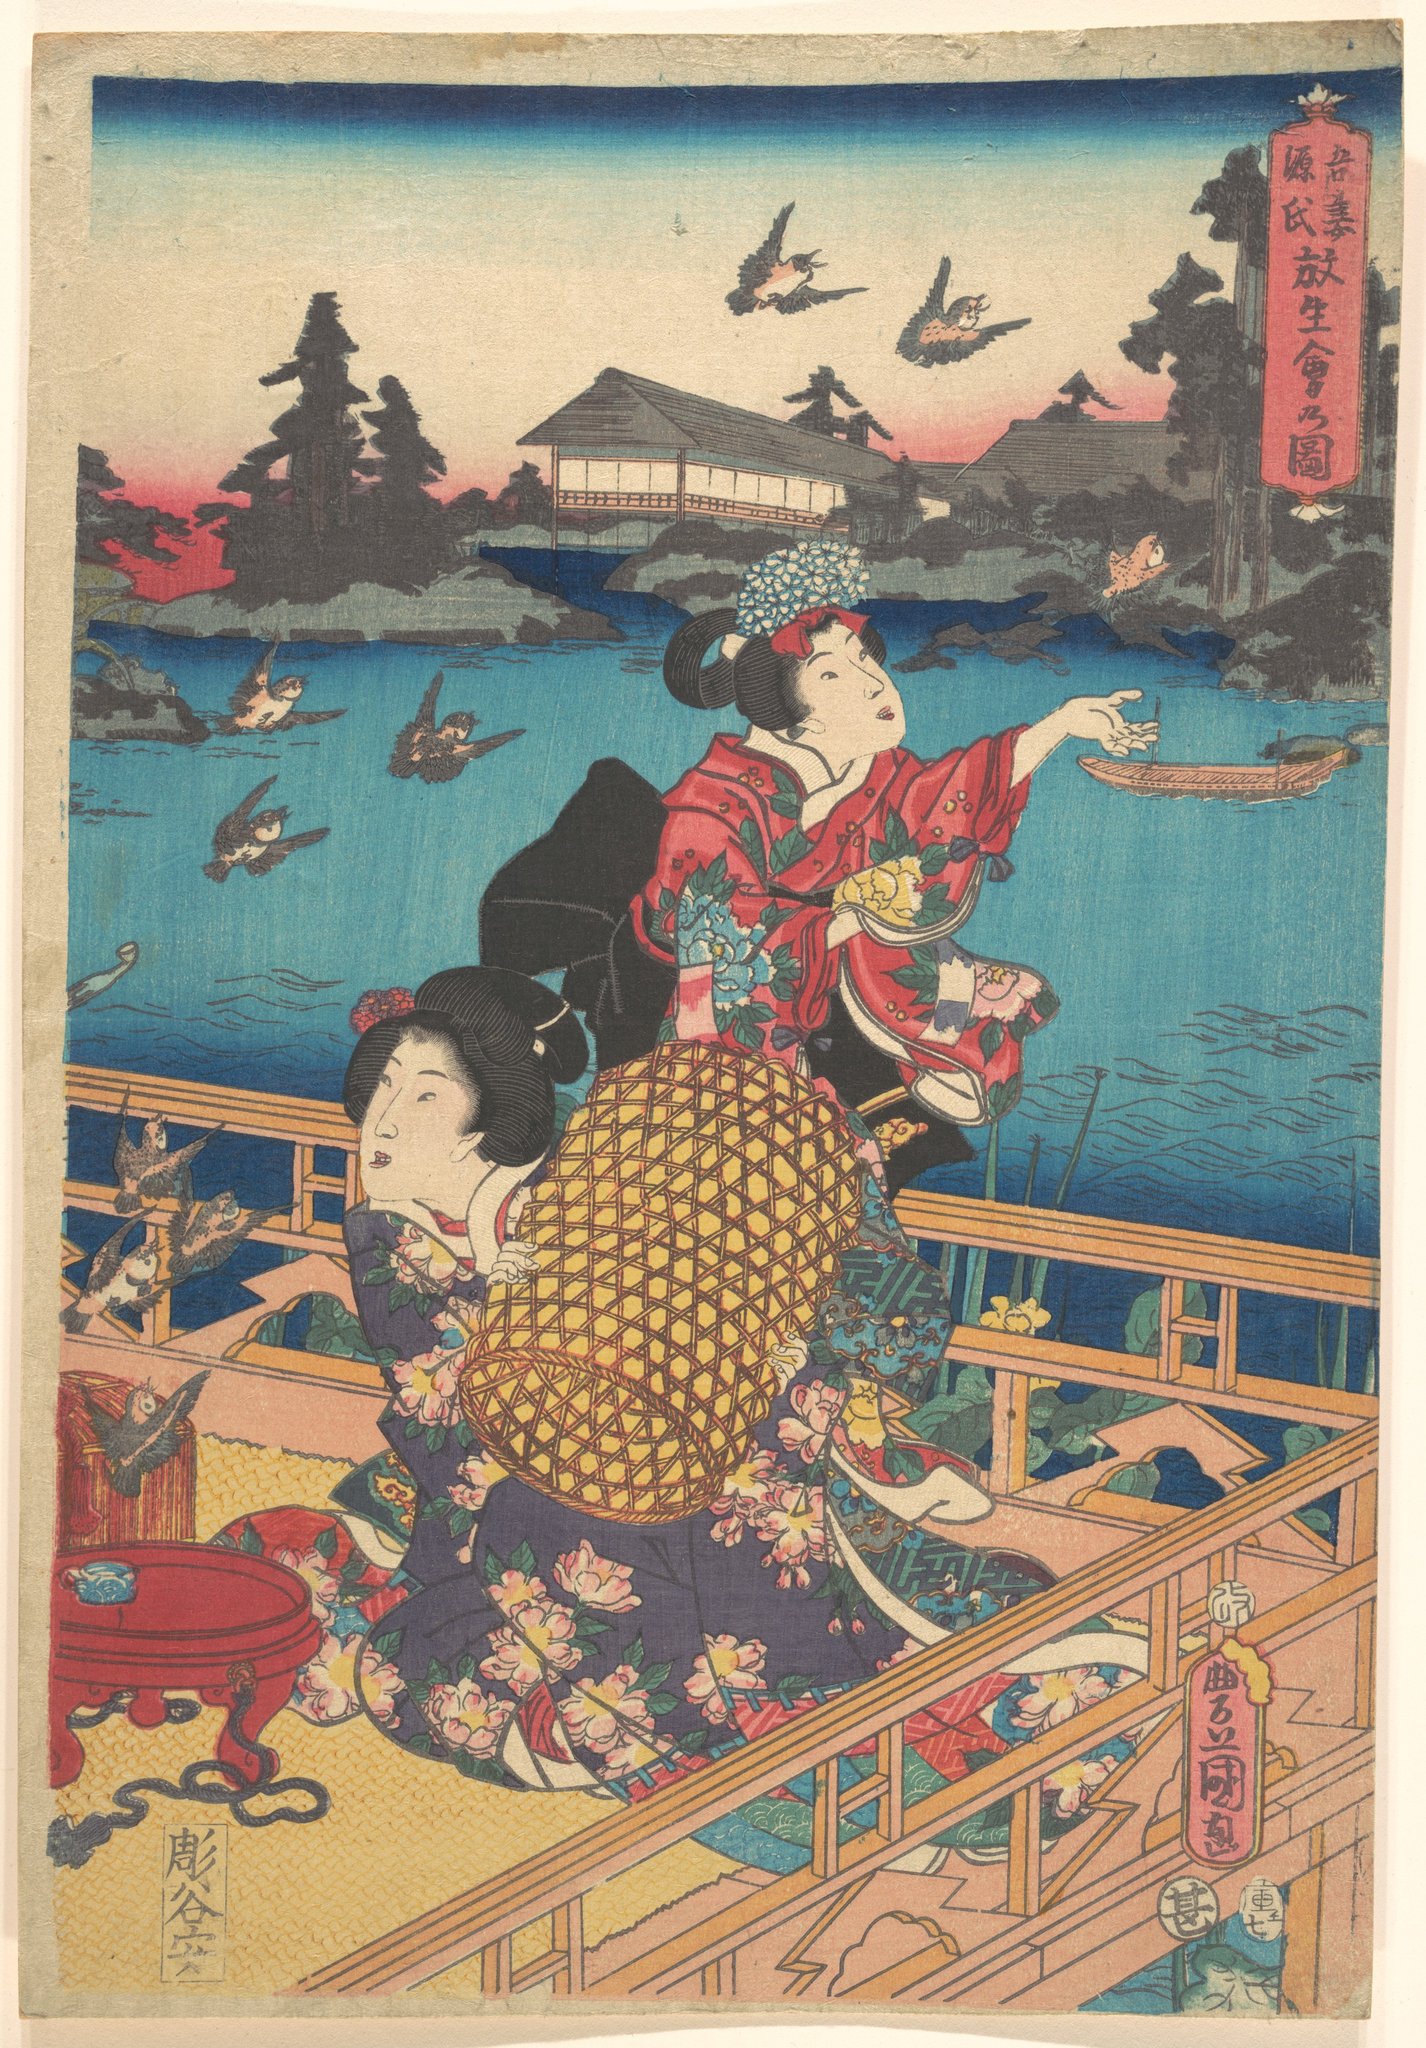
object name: print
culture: japanese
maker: utagawa kunisada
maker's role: artist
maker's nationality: japanese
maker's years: 1786-1864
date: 1786-1854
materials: ink, paper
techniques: woodblock print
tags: birds,women,boats